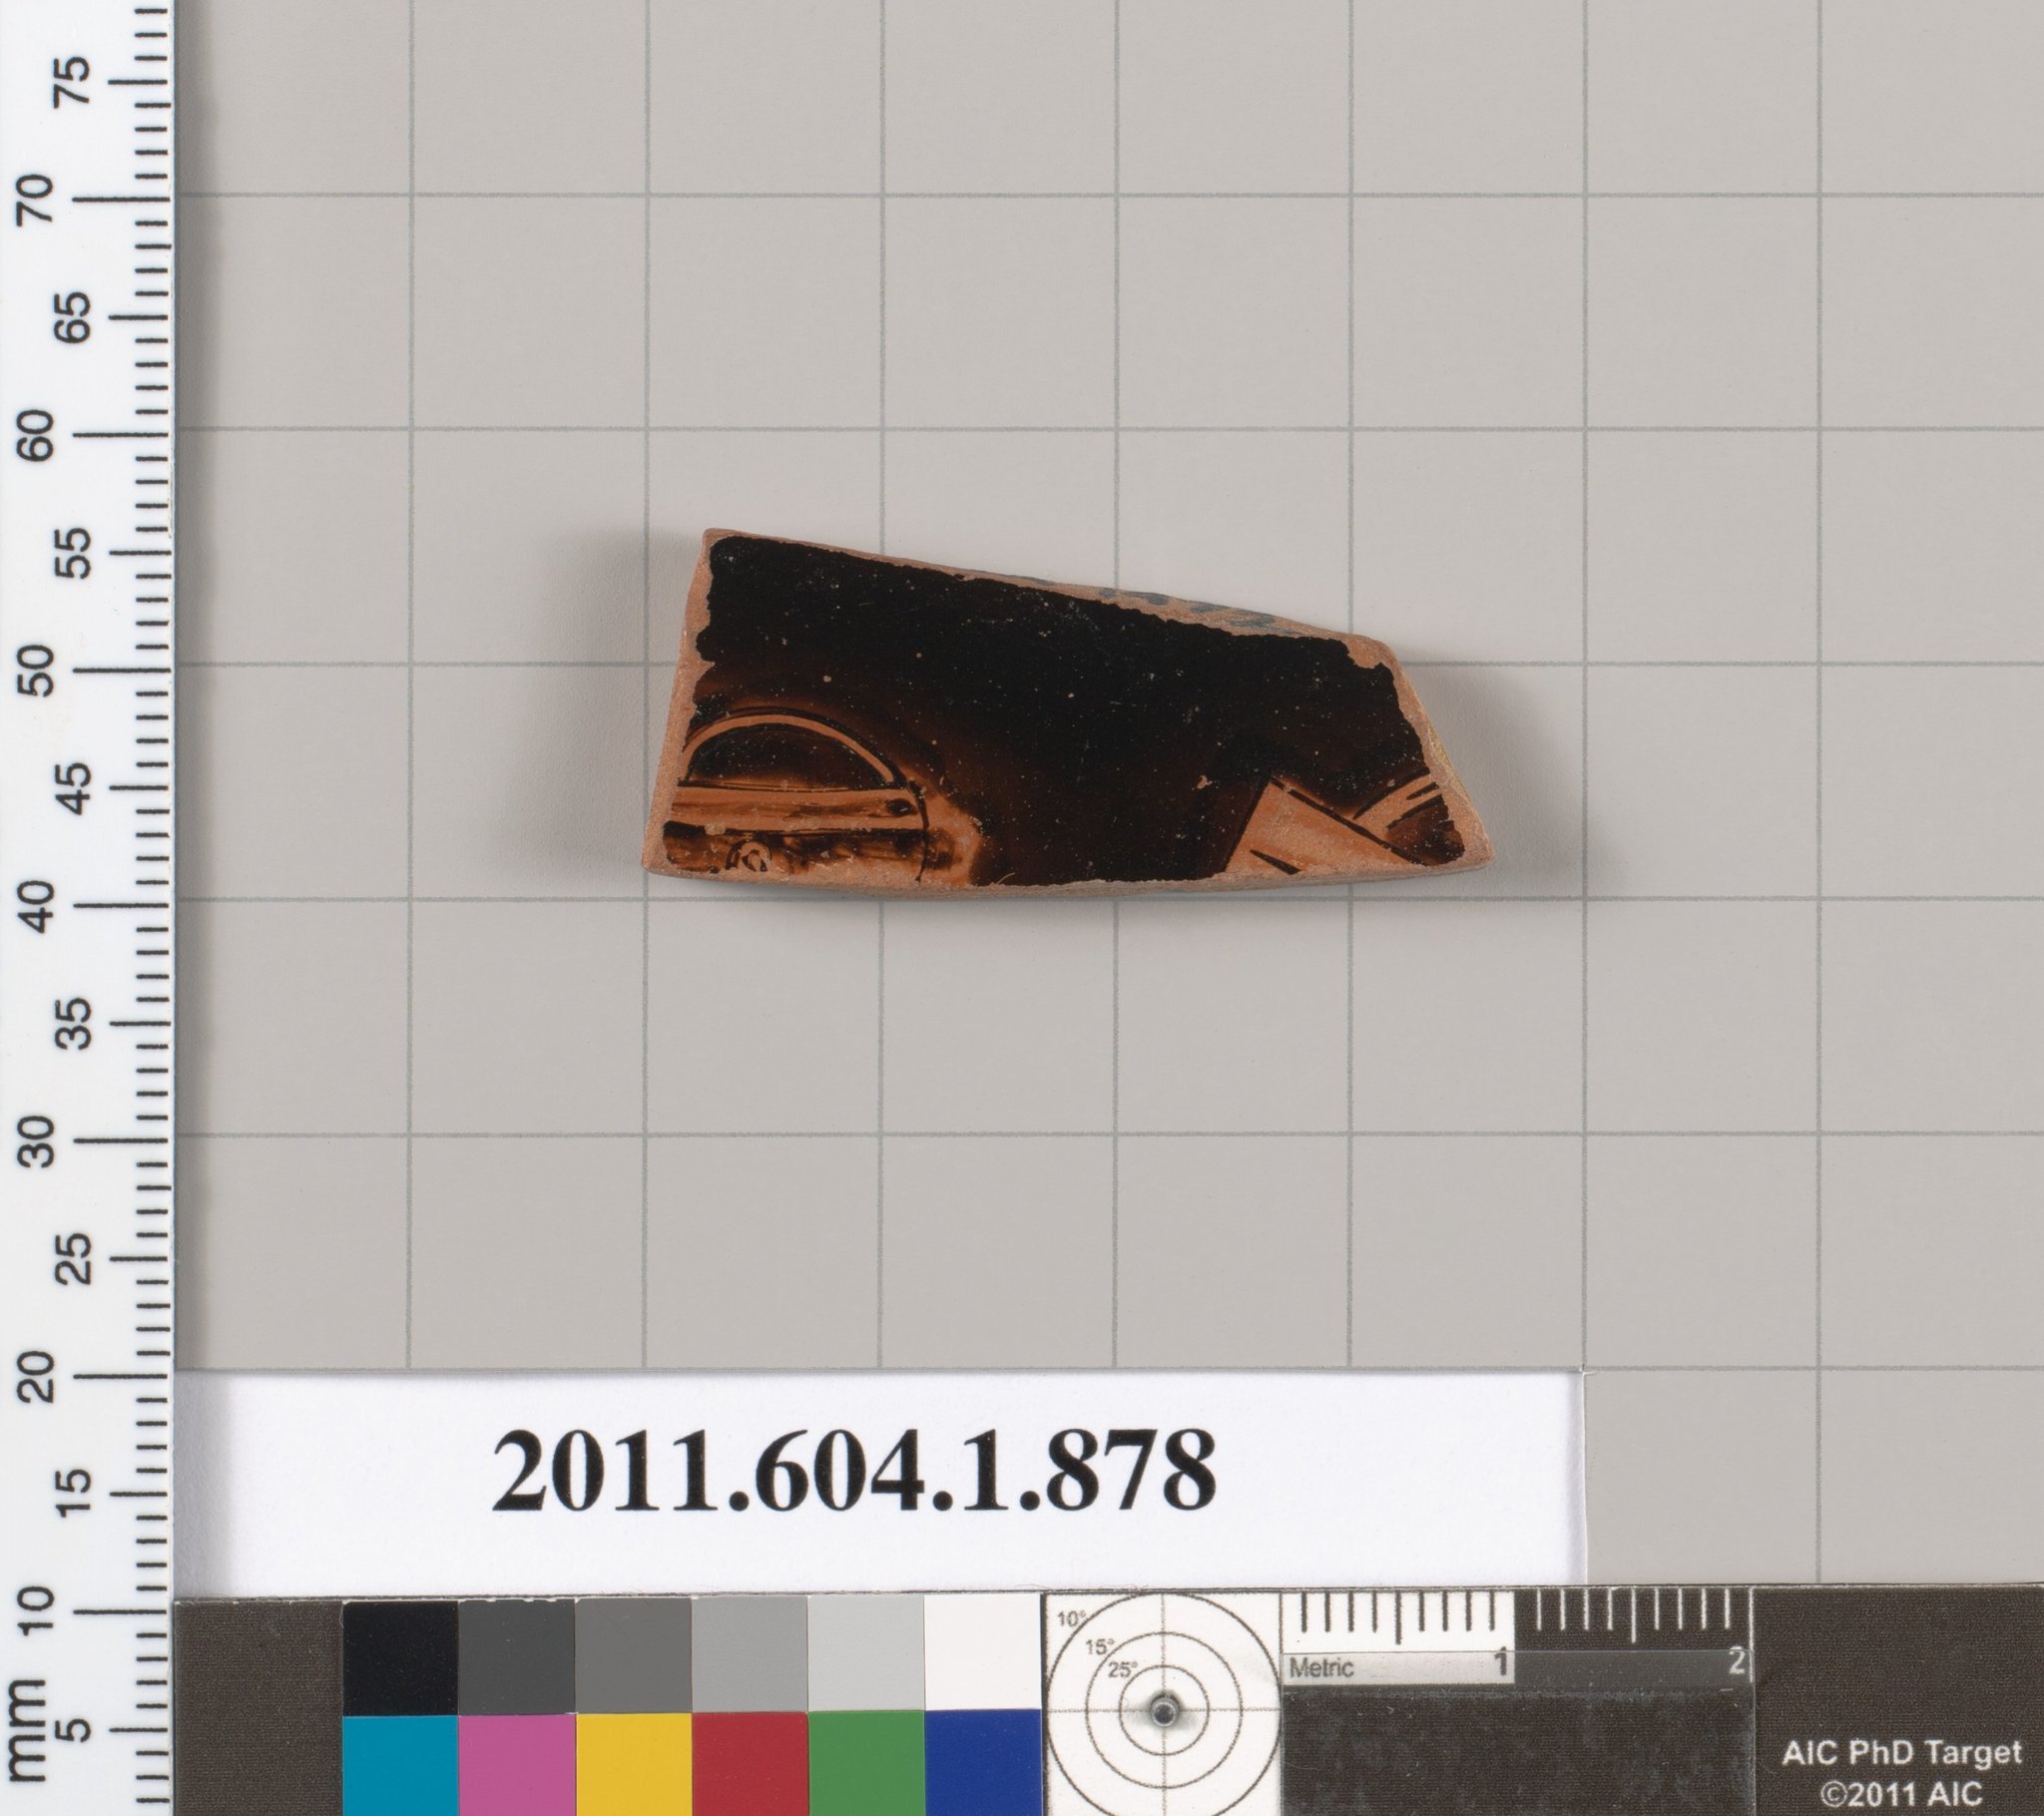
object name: kylix fragment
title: Terracotta fragment of a kylix (drinking cup)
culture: greek, attic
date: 500-476 BCE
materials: terracotta